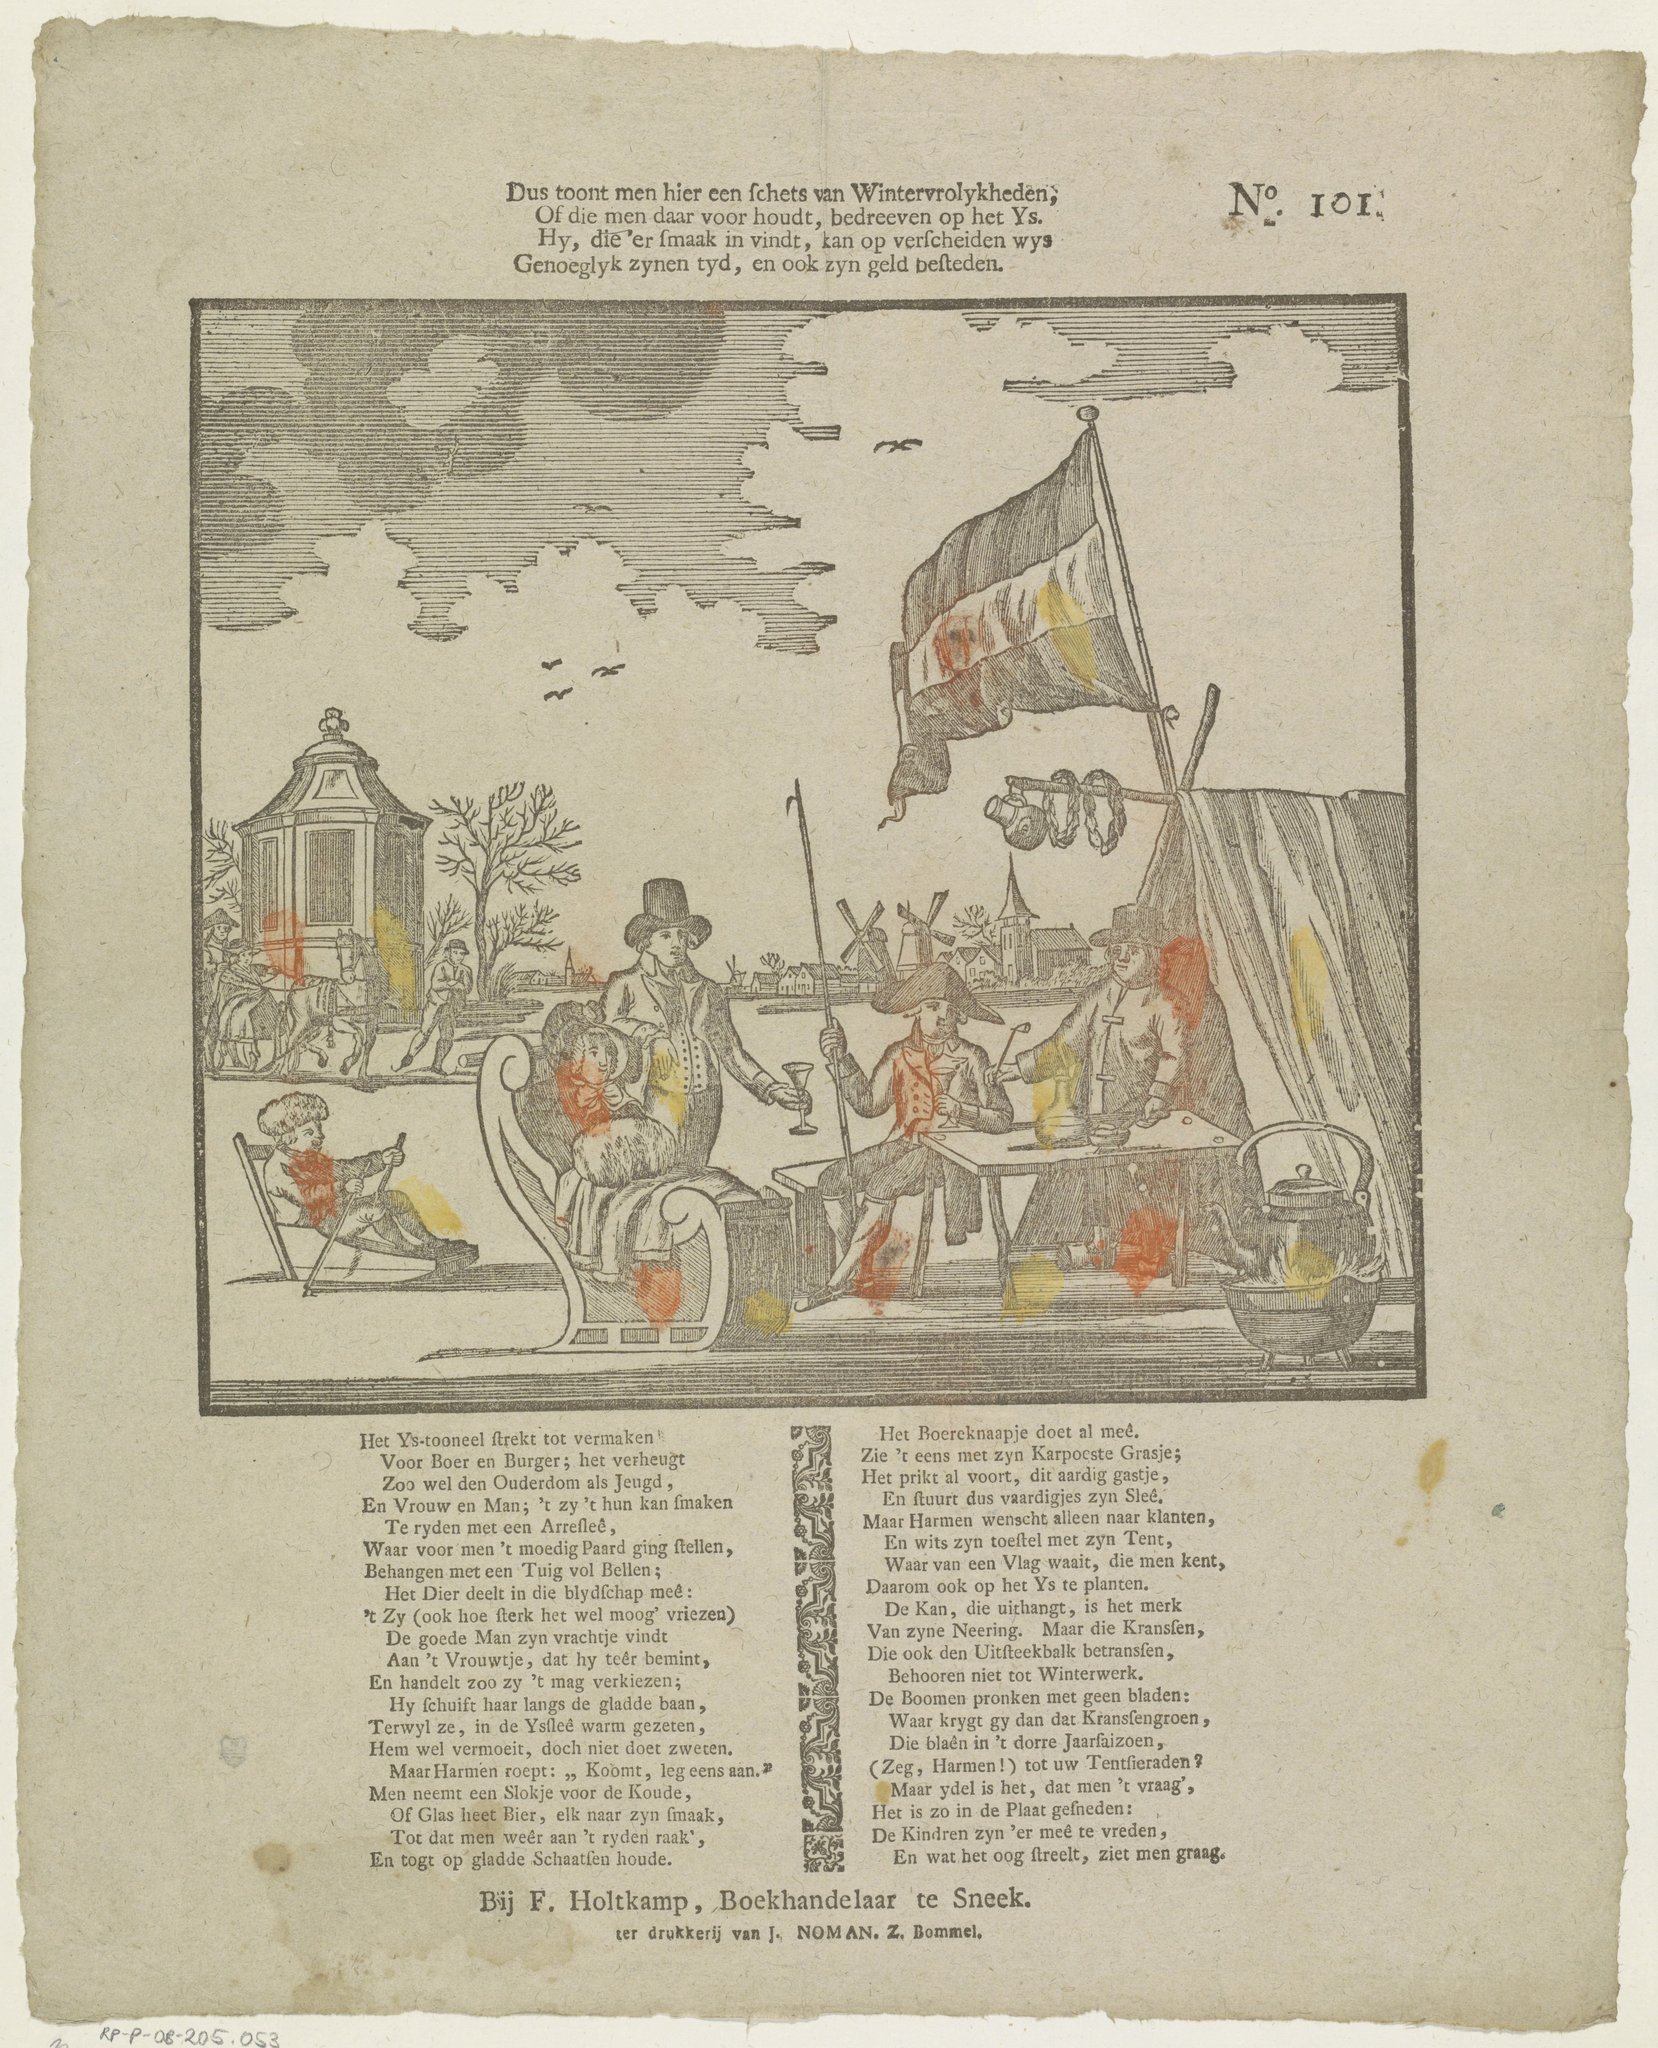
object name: print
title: Dus toont men hier een schets van wintervrolykheden, / Of die men daar voor houdt, bedreeven op het ys. / Hy, die 'er smaak in vindt, kan op verscheiden wys / Genoeglyk zynen tyd, en ook zyn geld besteden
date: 1806-1830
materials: paper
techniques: colour, letterpress printing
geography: sneek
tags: winter sports, skates (winter sports), sledge, sleigh (winter sports)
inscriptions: collector's mark: Lugt 2760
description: Blad met een grote voorstelling van een winters tafereel, met mensen die sleeën en schaatsen en een verkoper van warme drank. Onder de afbeelding een vers in twee kolommen. Genummerd rechtsboven: No. 101.